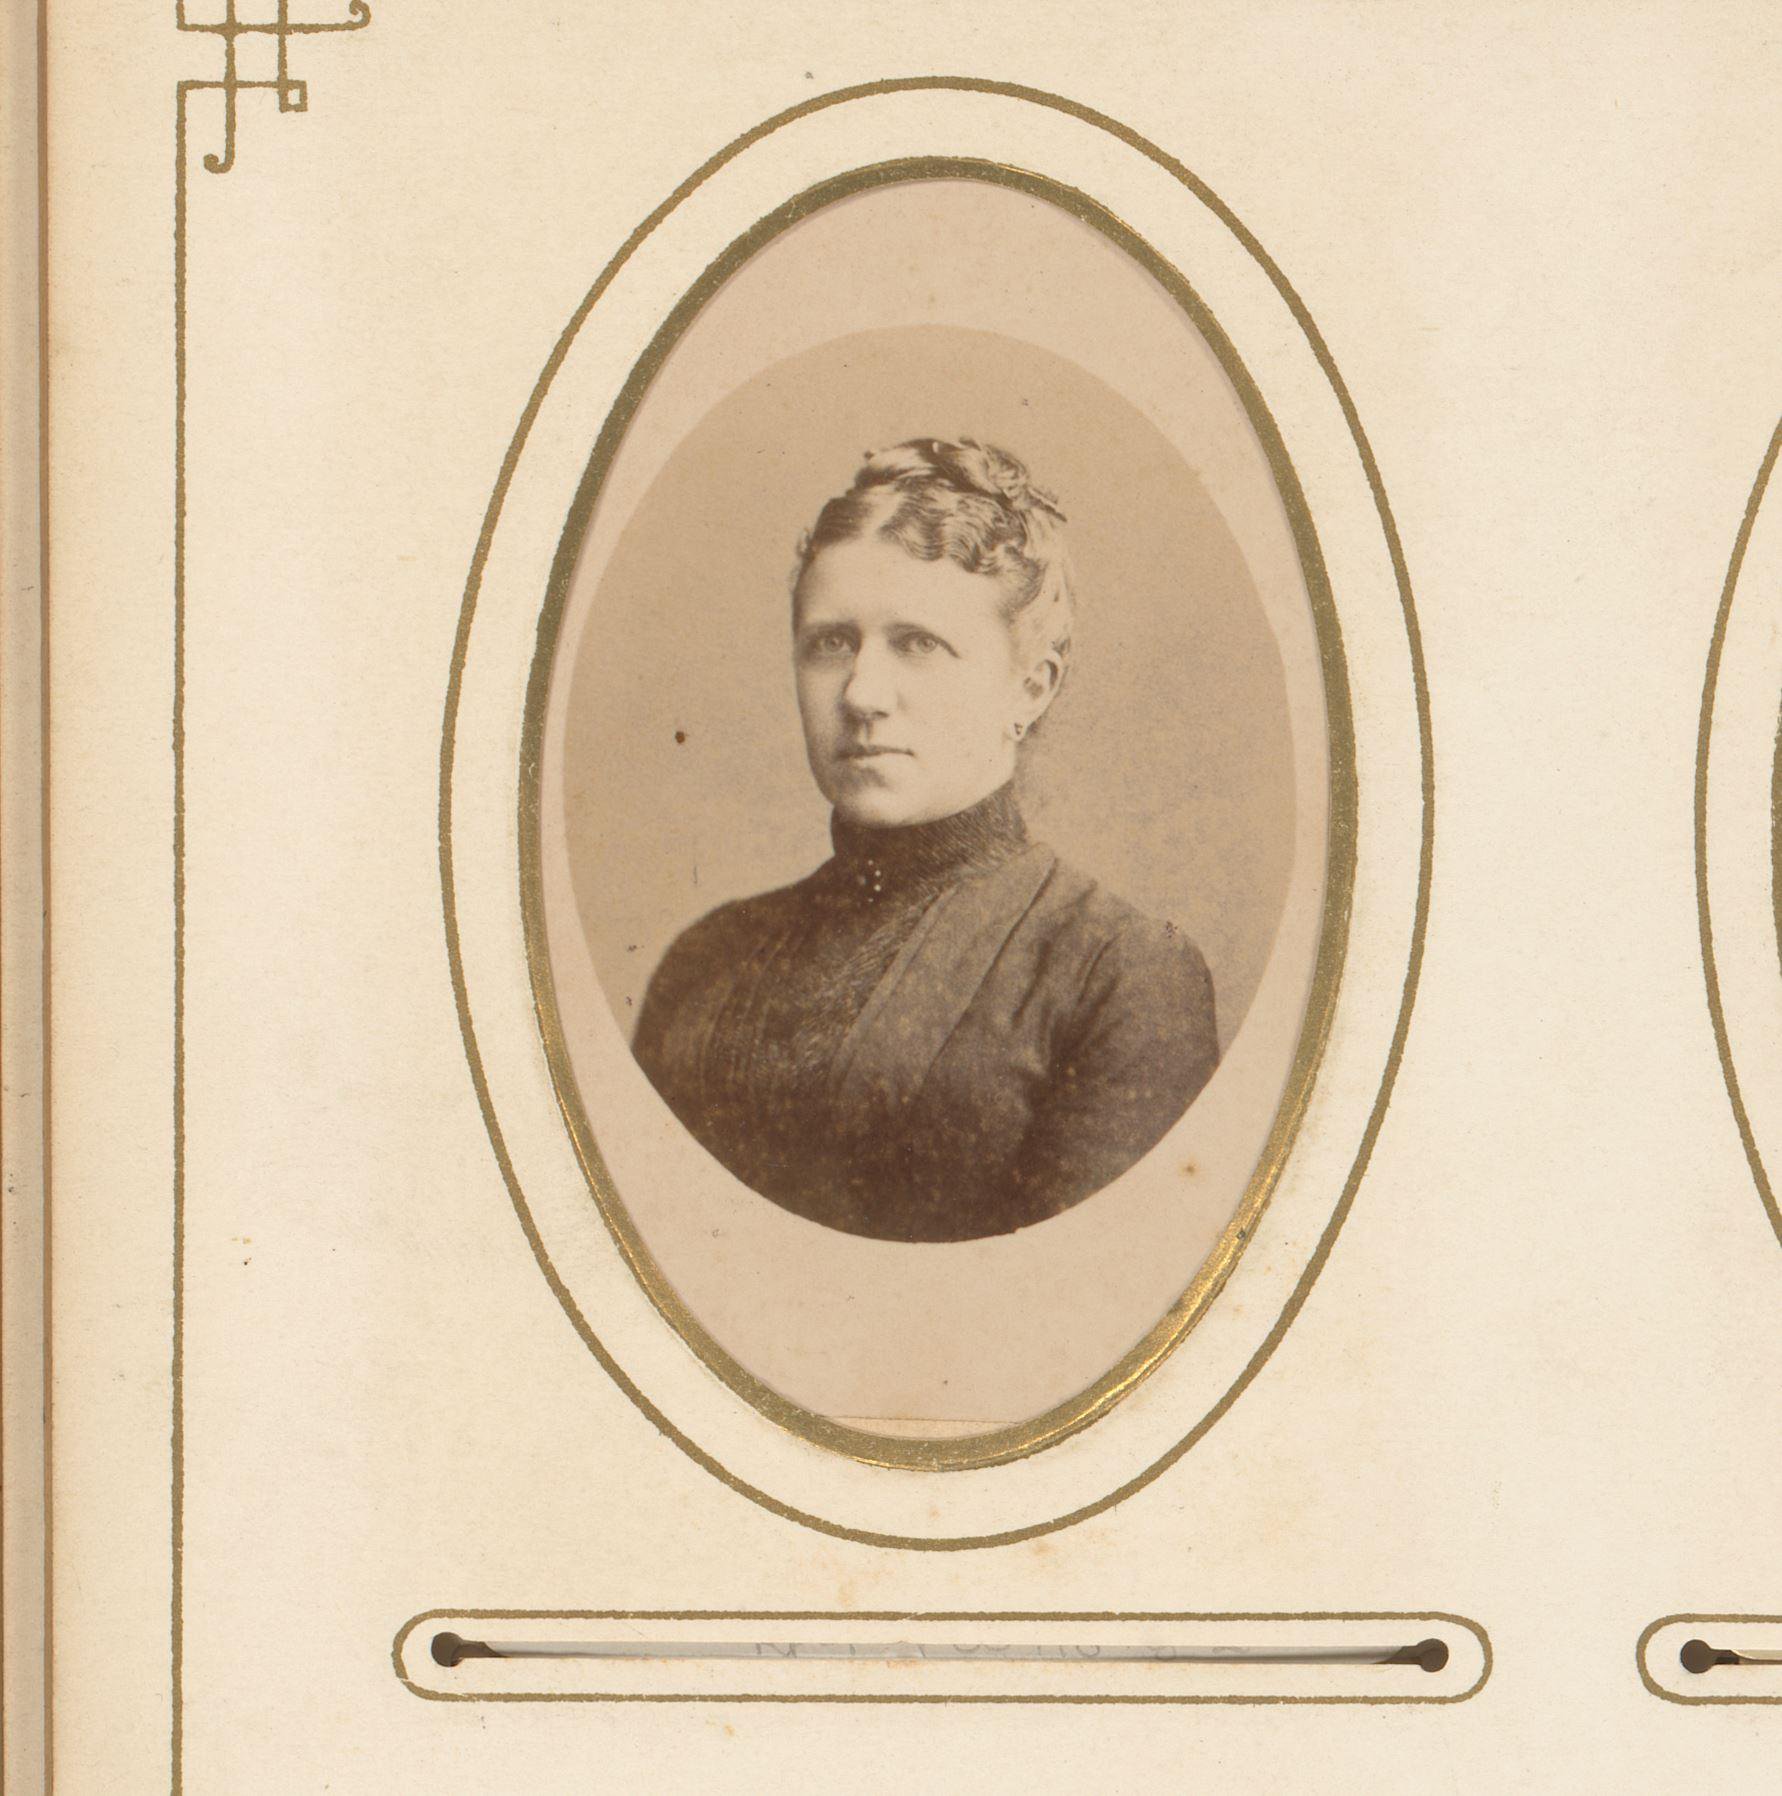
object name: carte de visite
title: Portret van een vrouw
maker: albert greiner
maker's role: fotograaf, fotostudio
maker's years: 1833-1890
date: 1861-1889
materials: cardboard, photographic support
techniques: albumen print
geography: amsterdam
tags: historical persons - bb - woman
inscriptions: inscription: ‘Albert Greiner/ Amsterdam’